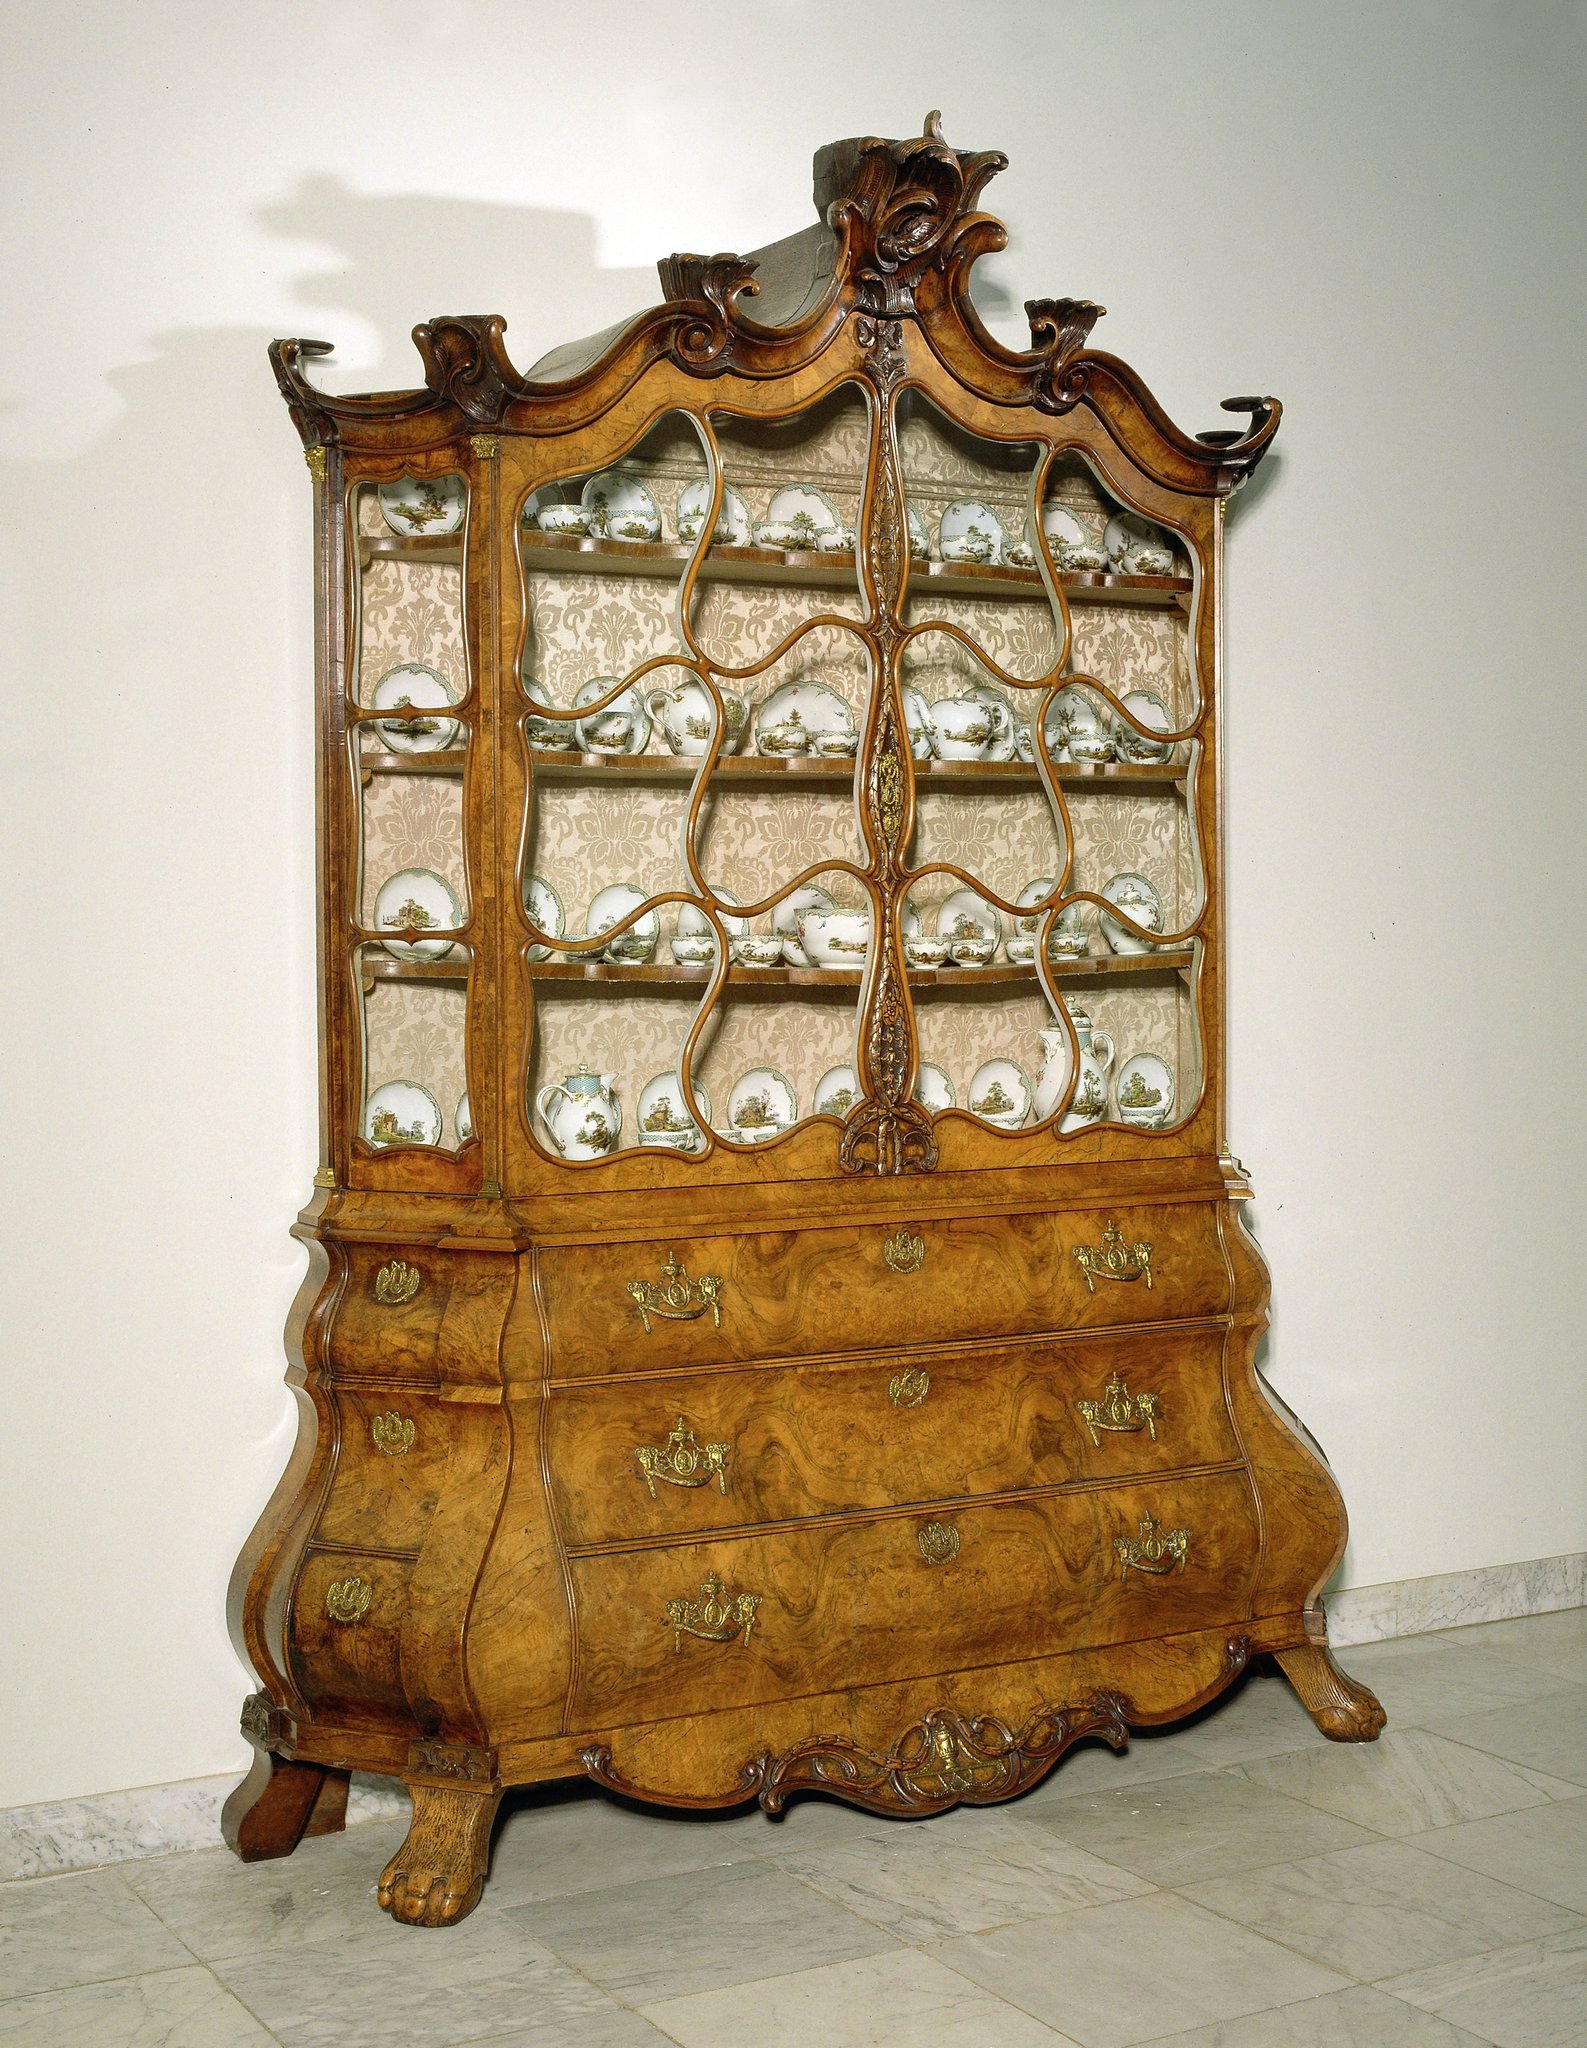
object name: china cabinet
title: Porseleinkast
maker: Anonymous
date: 1770-1775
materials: copper, glass, metal, wood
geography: netherlands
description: China cabinet. Oak, veneered with walnut and burr walnut, the glazing bars of mahogany. Netherlands, c. 1770 - 1775.